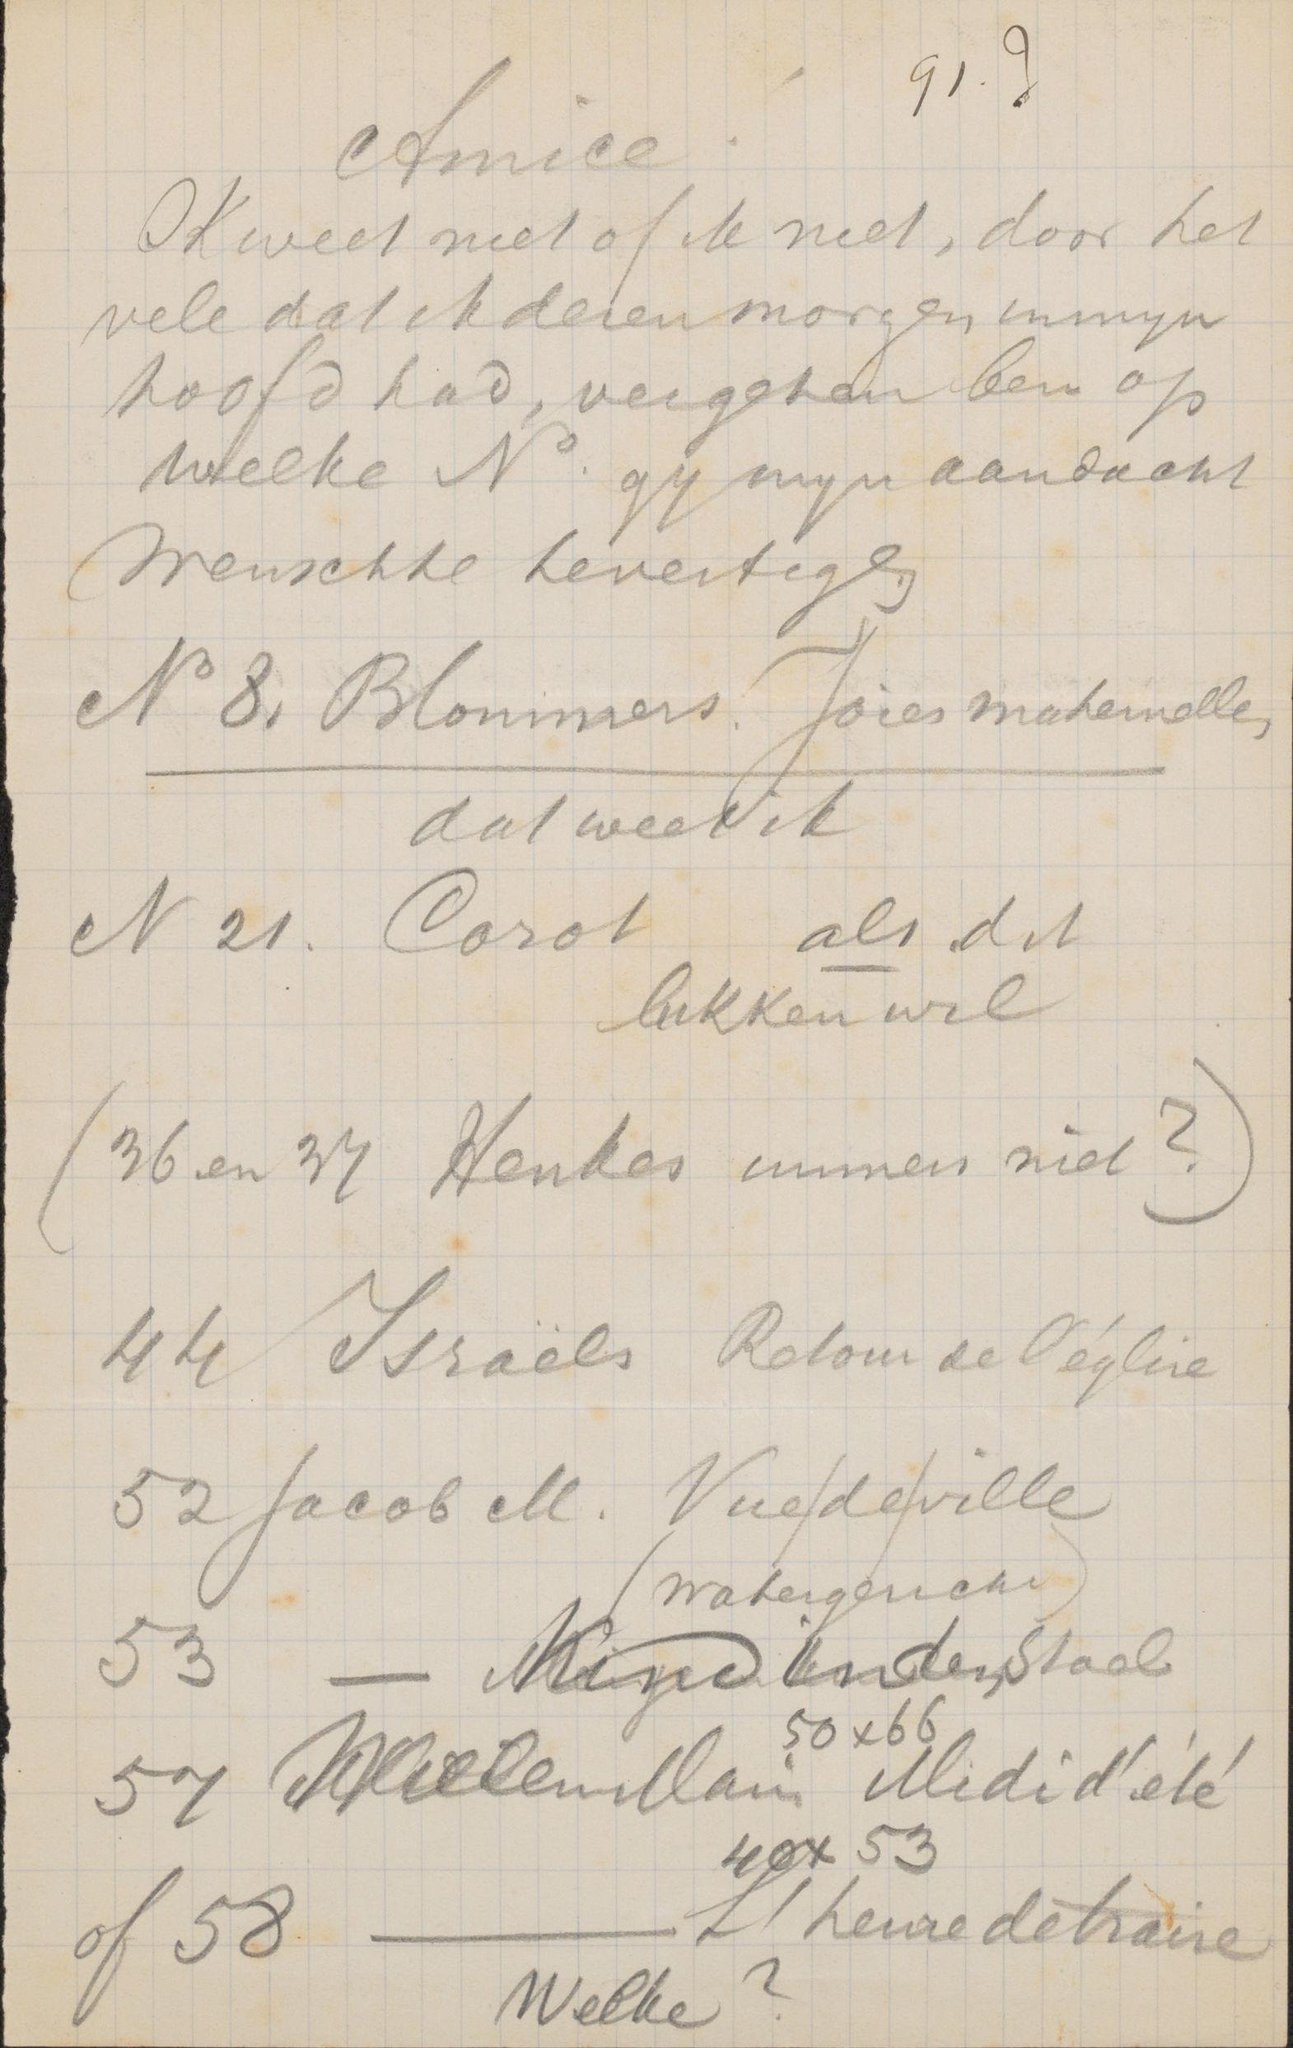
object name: letter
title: Brief aan Jan Veth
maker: martinus cornelis lebret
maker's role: verzamelaar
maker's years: 1833-1894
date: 1874-1894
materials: pencil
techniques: writing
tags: jozef israëls, bernardus johannes blommers, dordrecht, designer, jan veth, delfshaven, rotterdam, gerke henkes, paris, camille corot, willem maris, the hague, painter, print maker, draughtsman, jacob maris, art trade, art shop, art collecting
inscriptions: collector's mark: ‘RPK’